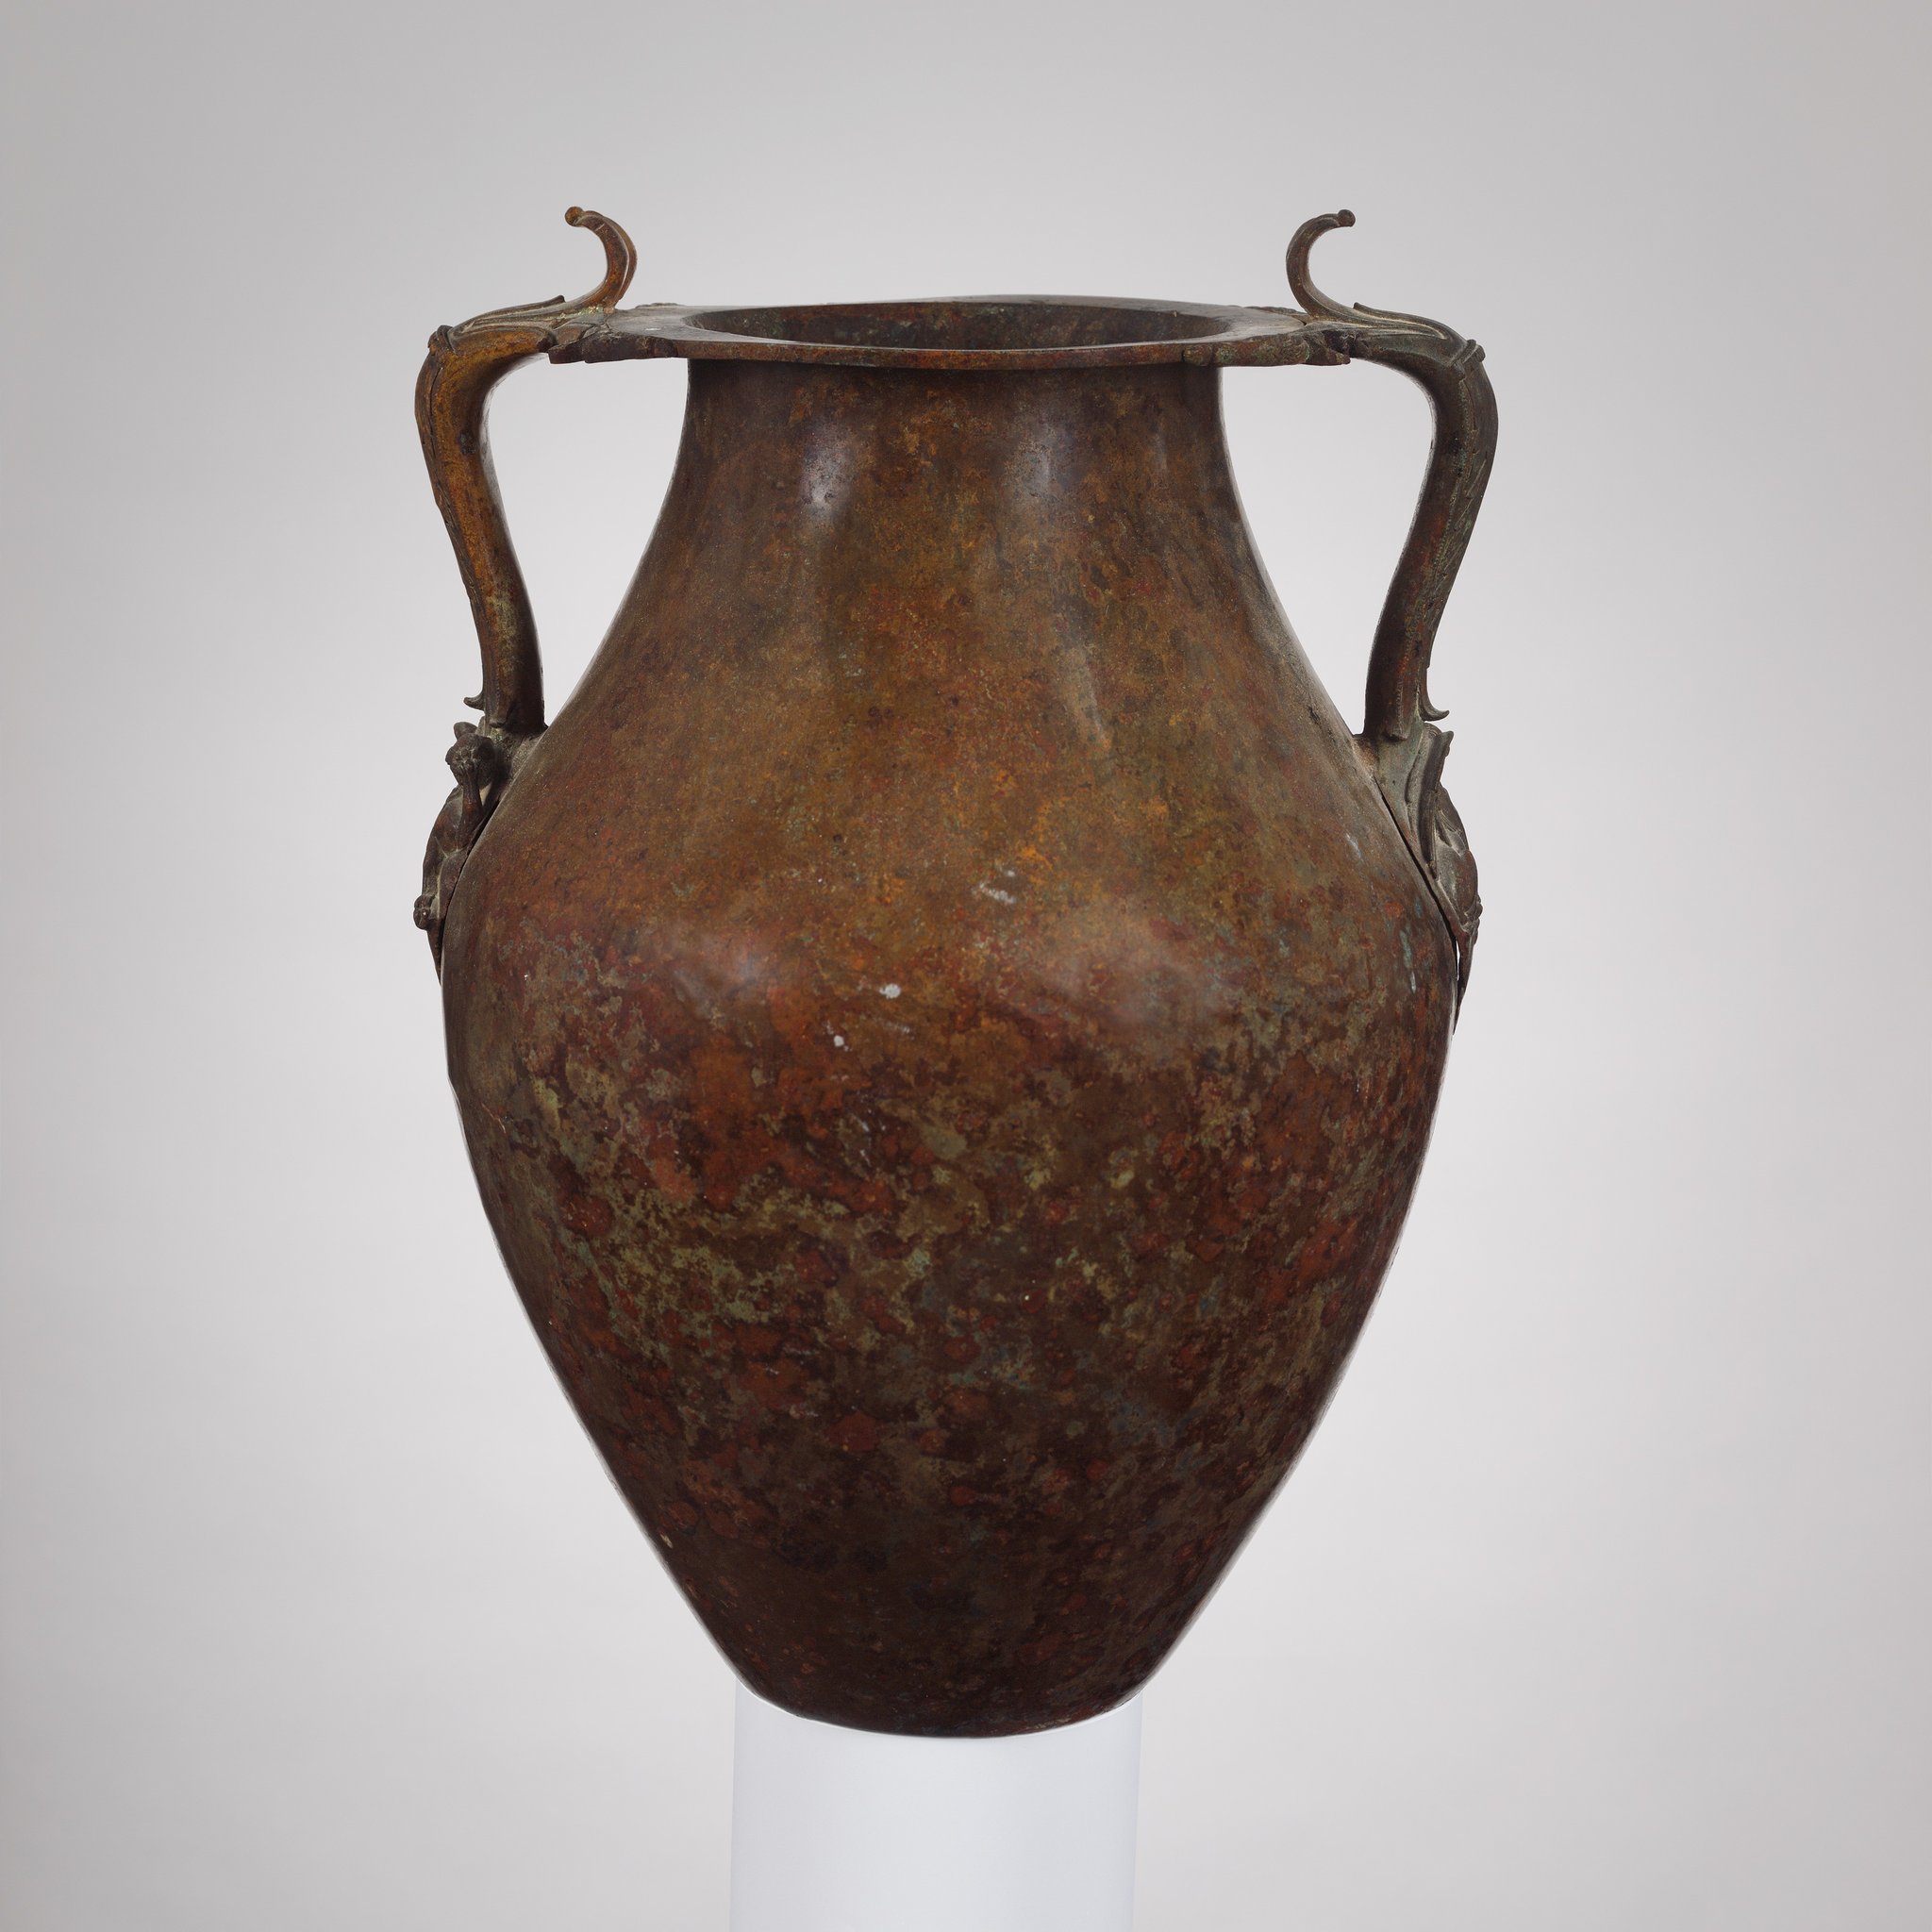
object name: amphora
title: Bronze jar with two handles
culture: roman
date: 1-100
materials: bronze